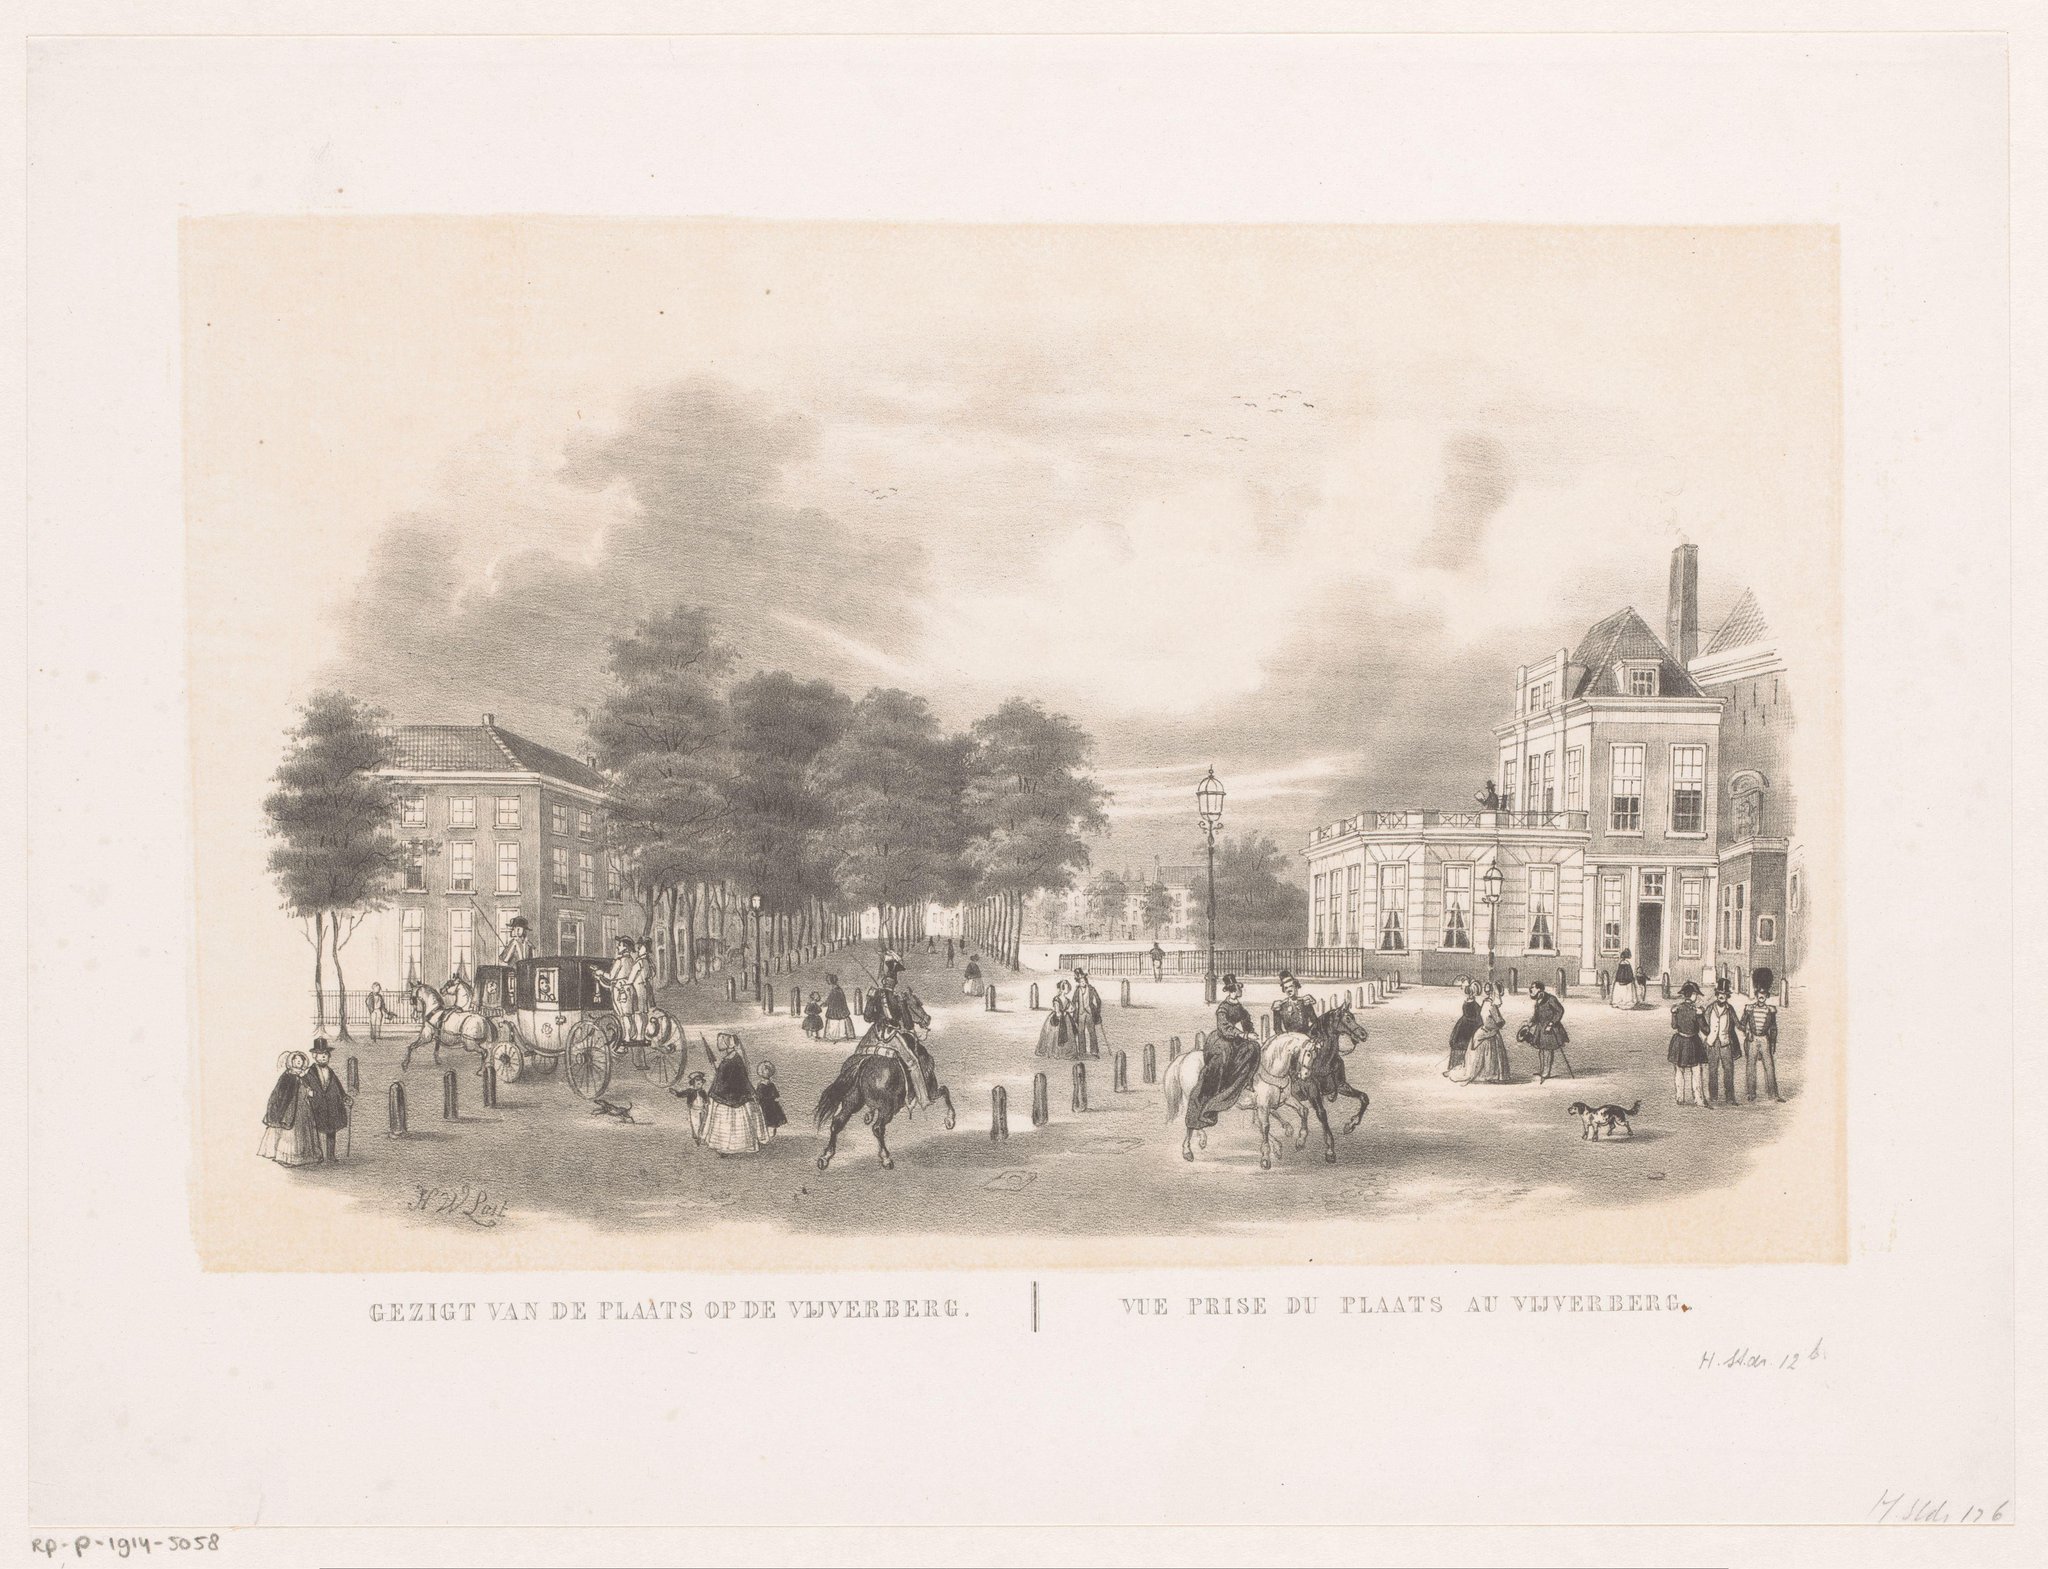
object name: print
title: Gezicht vanaf de Plaats naar de Vijverberg in Den Haag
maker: hendrik wilhelmus last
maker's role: print maker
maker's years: 1817-1873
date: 1827-1873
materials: paper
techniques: tone lithography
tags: village square, place (+ city(-scape) with figures, staffage)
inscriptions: collector's mark: Lugt 2228